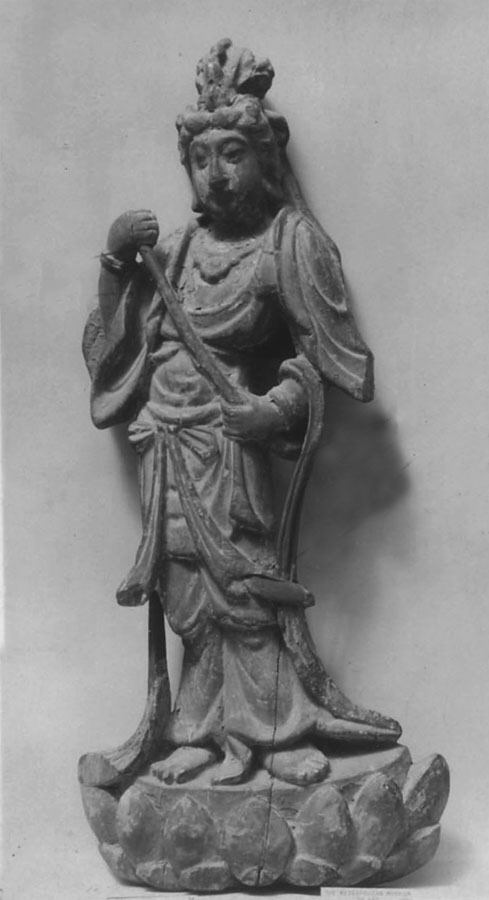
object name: statuette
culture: chinese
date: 618-907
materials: wood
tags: men